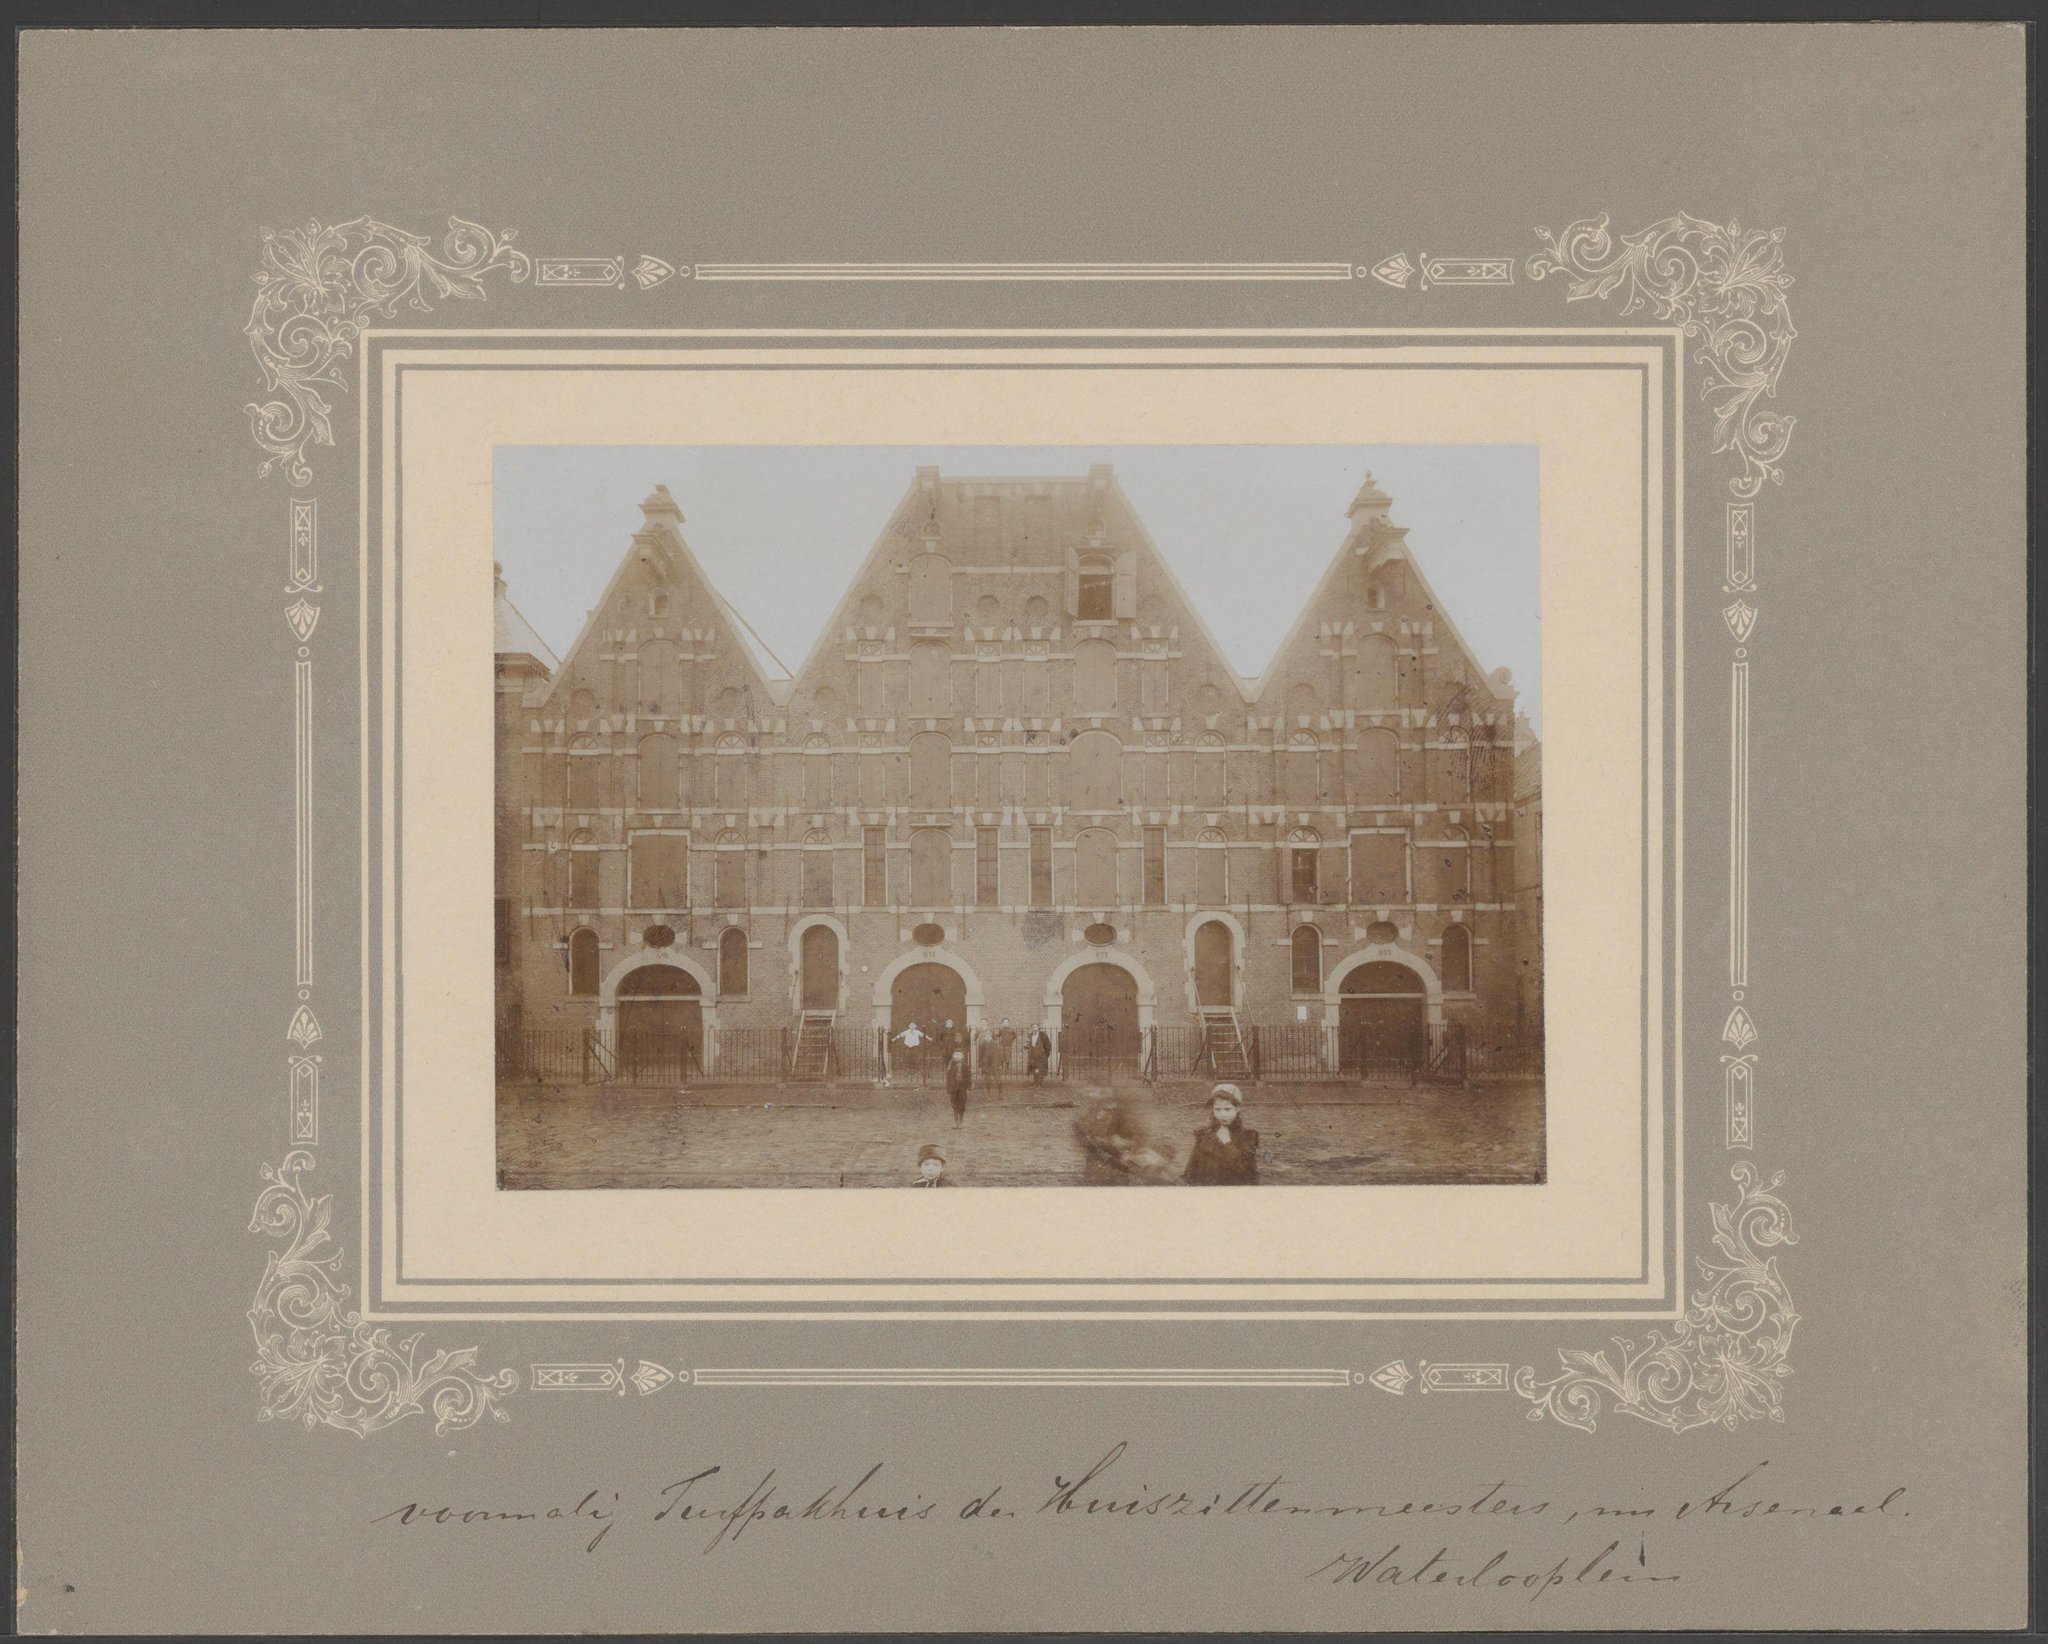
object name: photograph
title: Gezicht op het Arsenaal te Amsterdam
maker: Anonymous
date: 1880-1920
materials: paper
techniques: collodion silver print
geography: amsterdam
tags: large-scale structure for storage, e.g.: warehouse, depot, silo, square, place, circus, etc. (+ city(-scape) with figures, staffage)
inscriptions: collector's mark: Lugt 1641b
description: Gezicht op het Arsenaal te Amsterdam vanaf het Waterlooplein. Onderwerpsrubriek binnen de Atlas Amsterdam: Armwezen en liefdadige instellingen: I. Stadsinrichtingen: Stedelijk Armenhuis - Huiszittenhuizen - Huiszitten Weduwenhof.